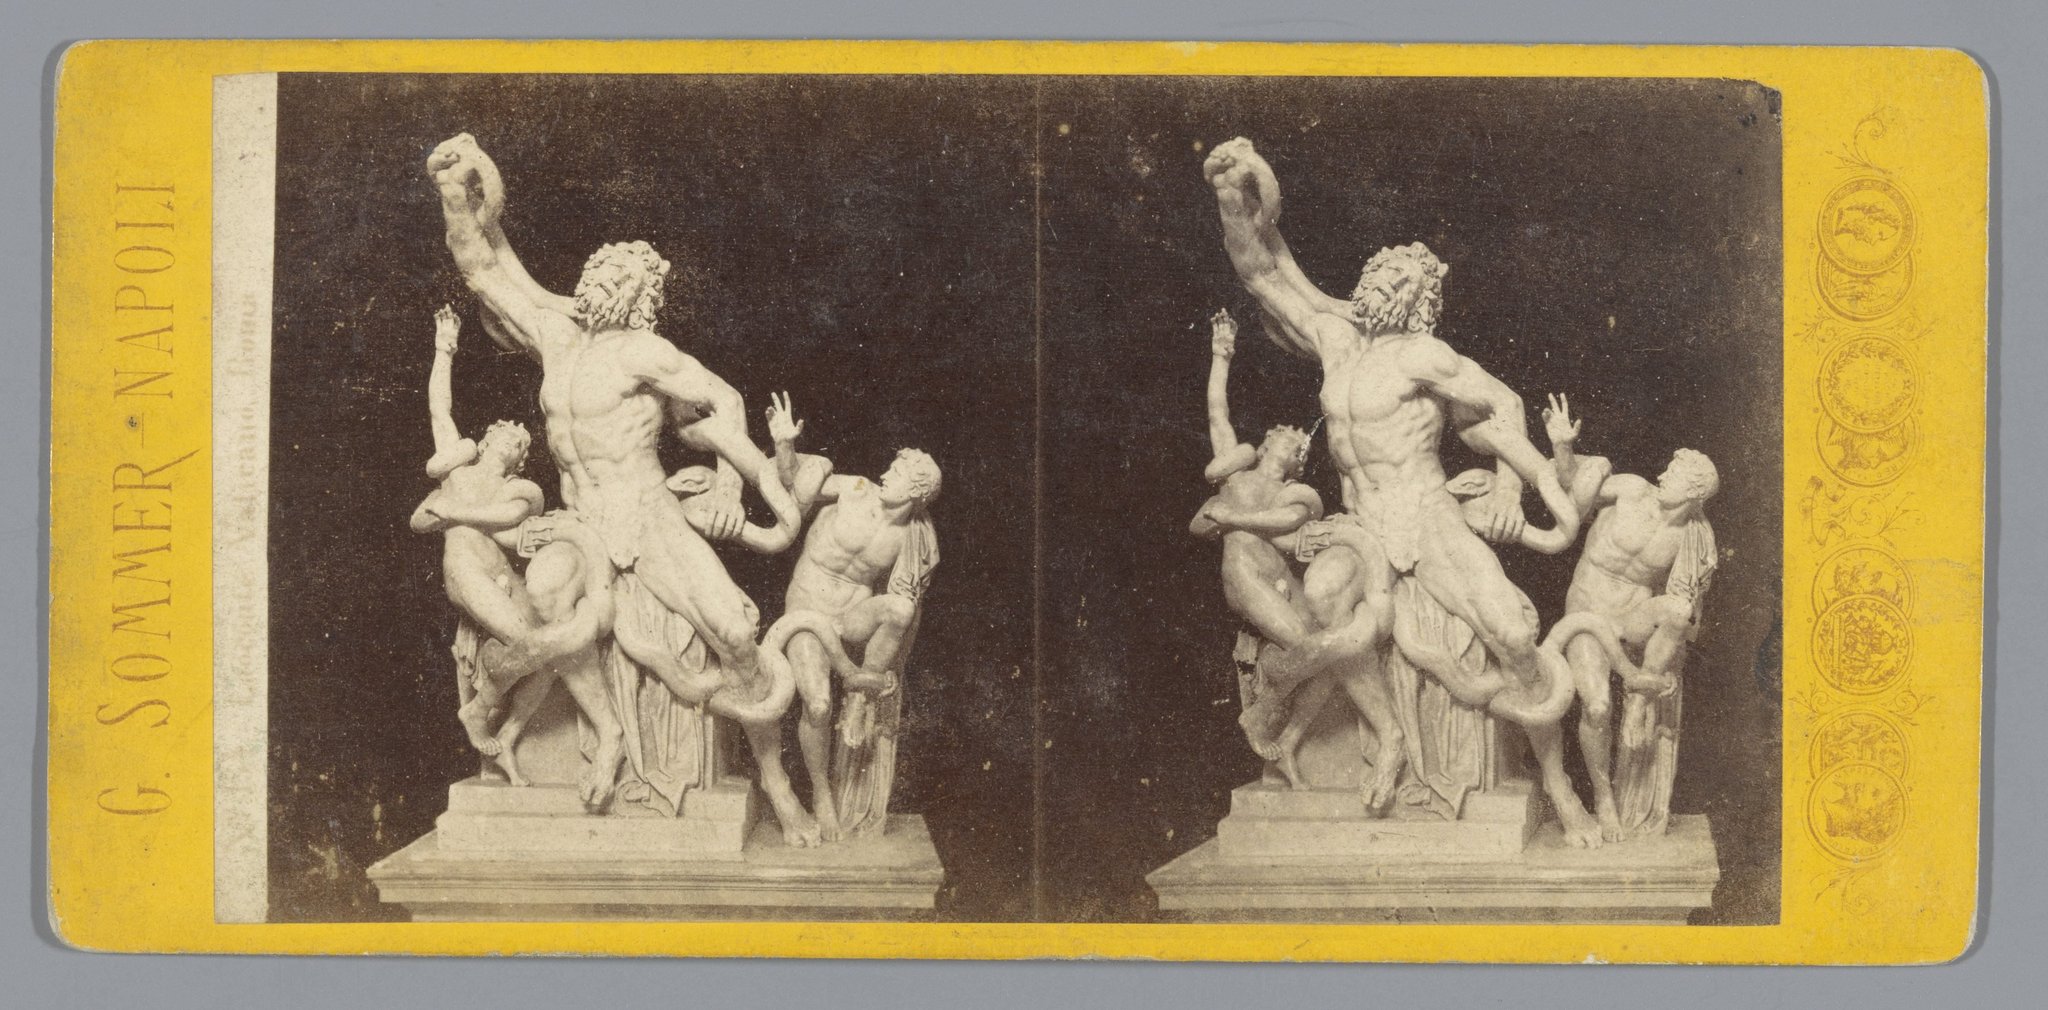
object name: stereograph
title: Laoco[(...)] Vaticano, Roma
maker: giorgio sommer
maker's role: fotograaf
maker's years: 1834-1914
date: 1860-1880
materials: cardboard, photographic support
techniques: albumen print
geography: vatican museums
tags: laocoon and his twin sons are strangled by two serpents during the preparations for a sacrifice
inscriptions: inscription: ‘Rome: Vaticaan: Laocoon’